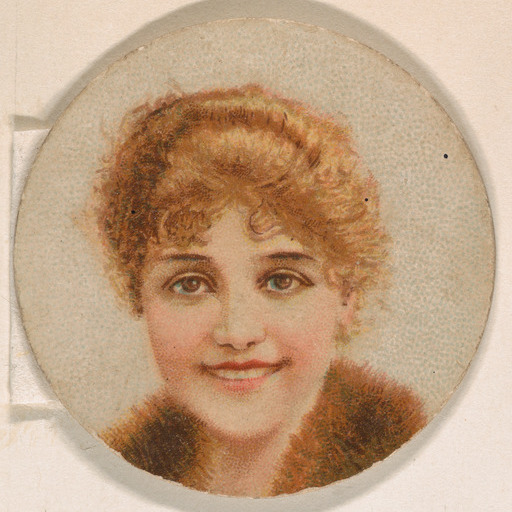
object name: print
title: Portrait of woman, from the Novelties series (N228, Type 1) issued by Kinney Bros.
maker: kinney brothers tobacco company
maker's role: publisher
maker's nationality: american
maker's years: 1869-2011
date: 1889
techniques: color lithograph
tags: portraits,women